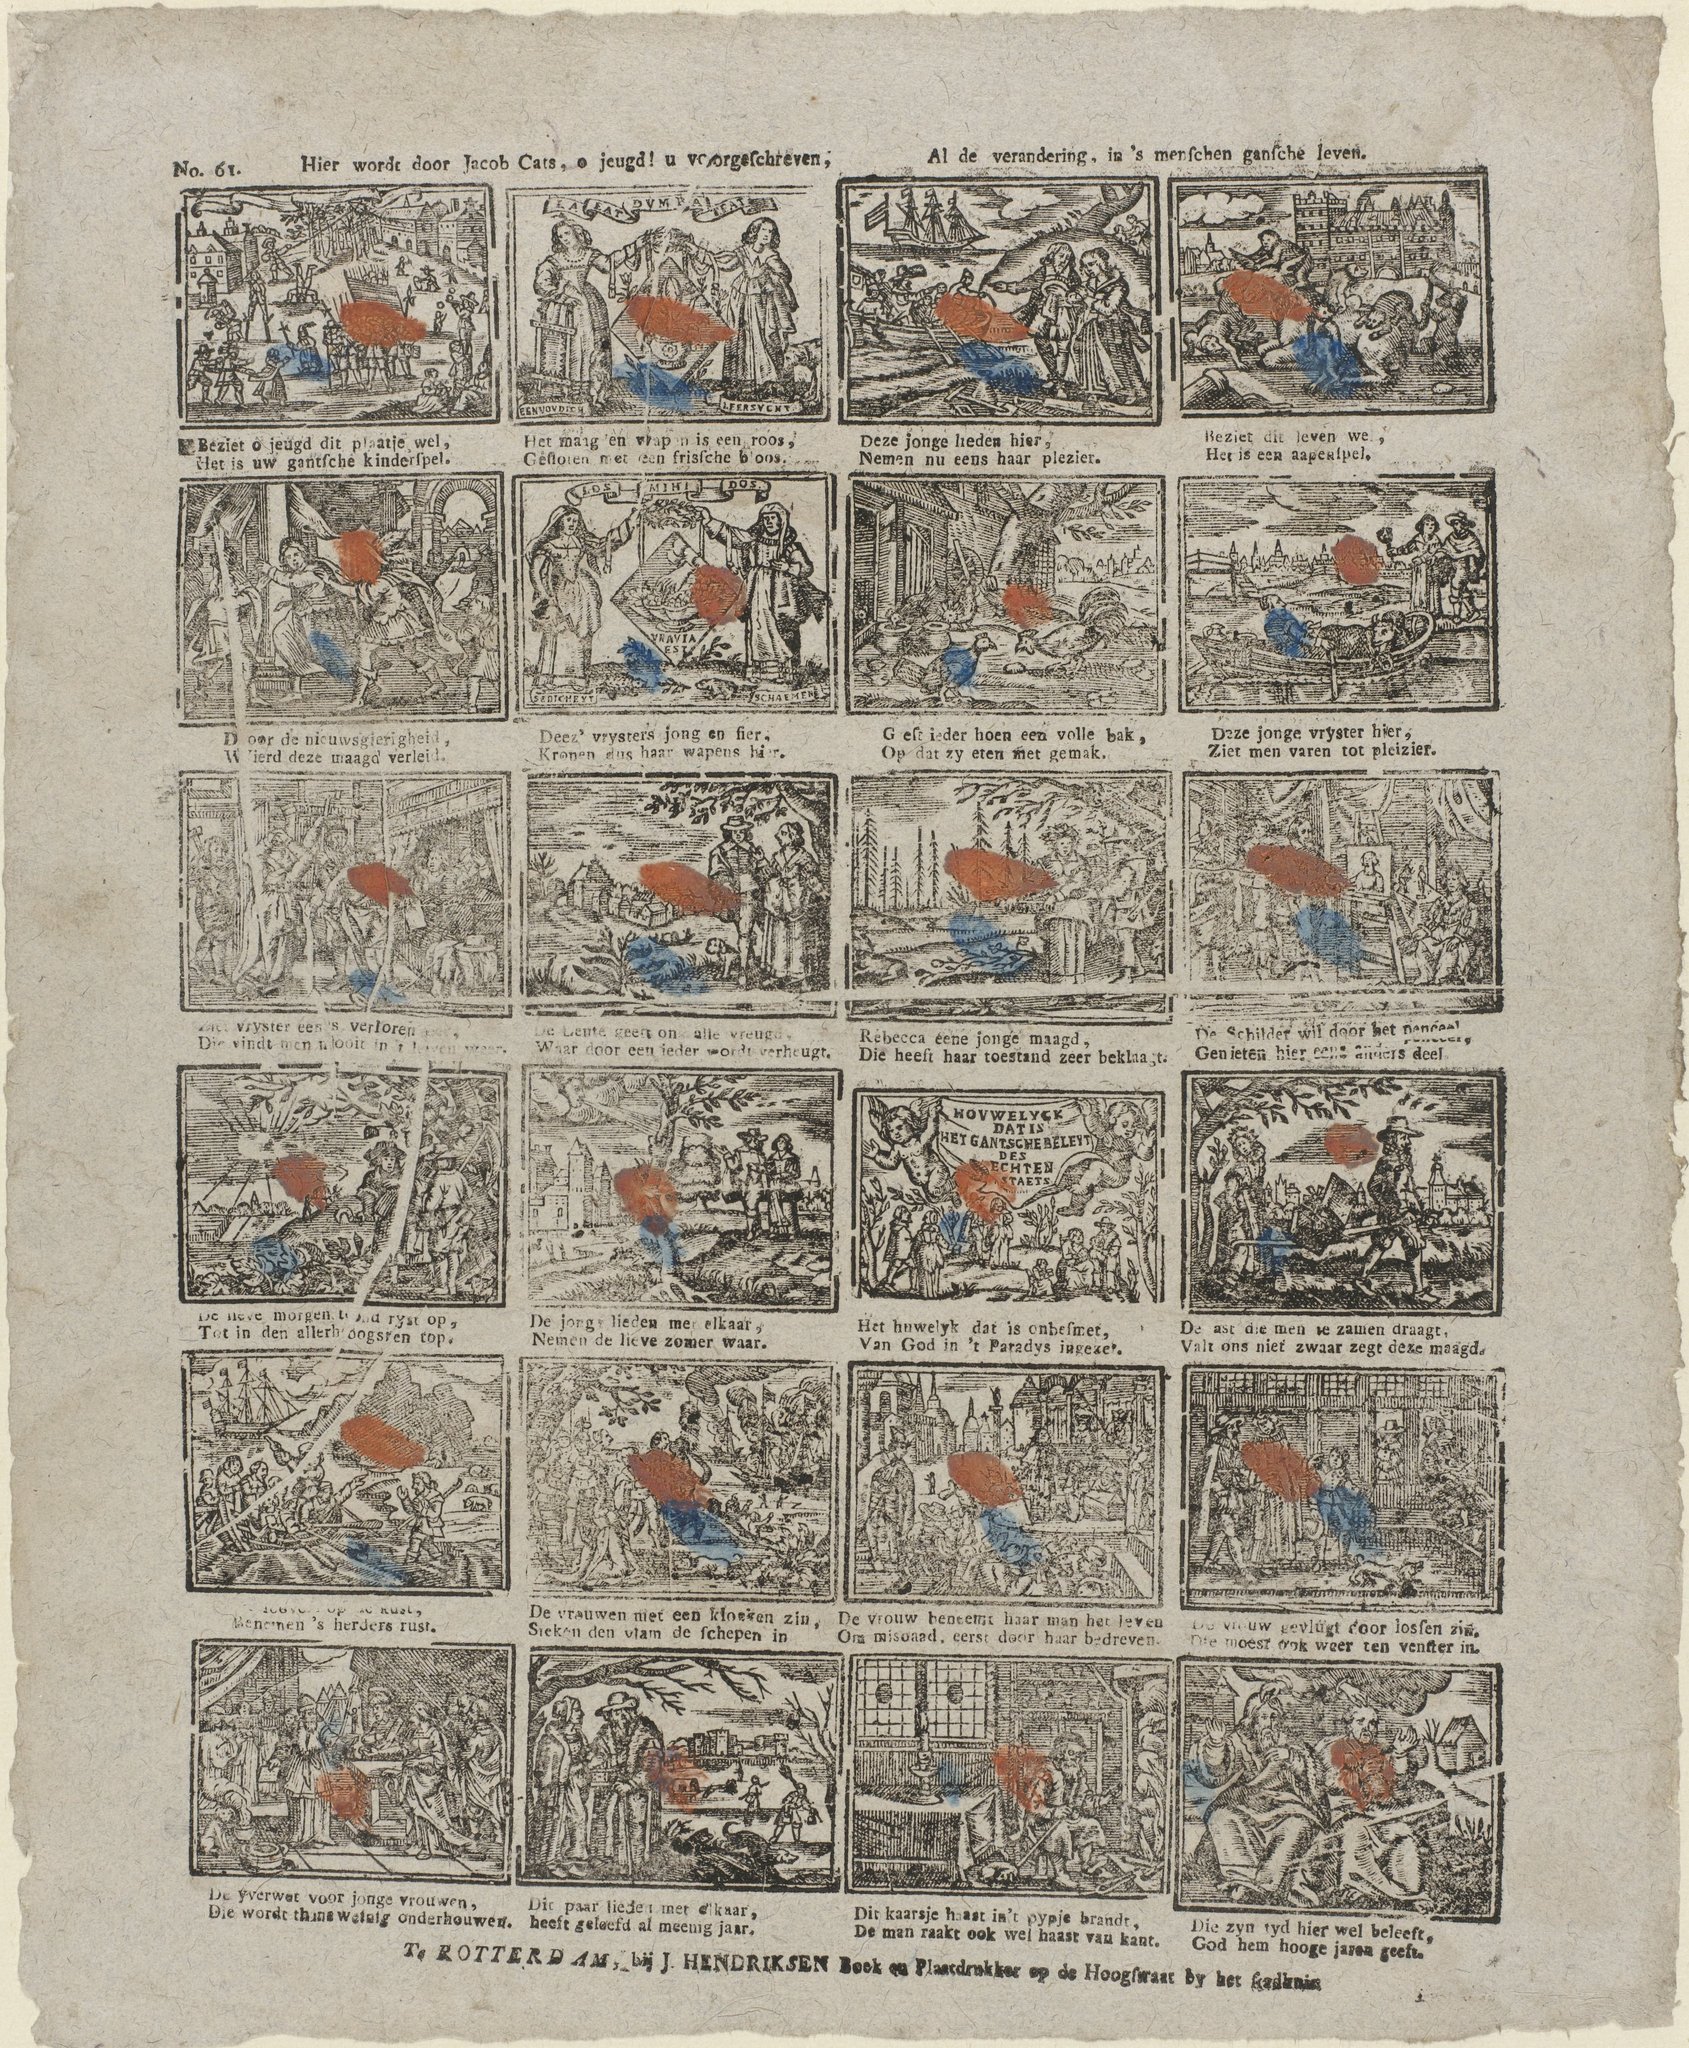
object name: print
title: Hier wordt door Jacob Cats, o jeugd! u voorschreven, Al de verandering in 's menschen gansche leven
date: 1781-1828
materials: paper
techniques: colour, letterpress printing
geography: rotterdam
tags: lovers' meeting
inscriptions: collector's mark: Lugt 2760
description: Blad met 24 voorstellingen van verschillende figuren en bezigheden. Onder elke afbeelding een tweeregelig vers. Genummerd linksboven: No. 61.